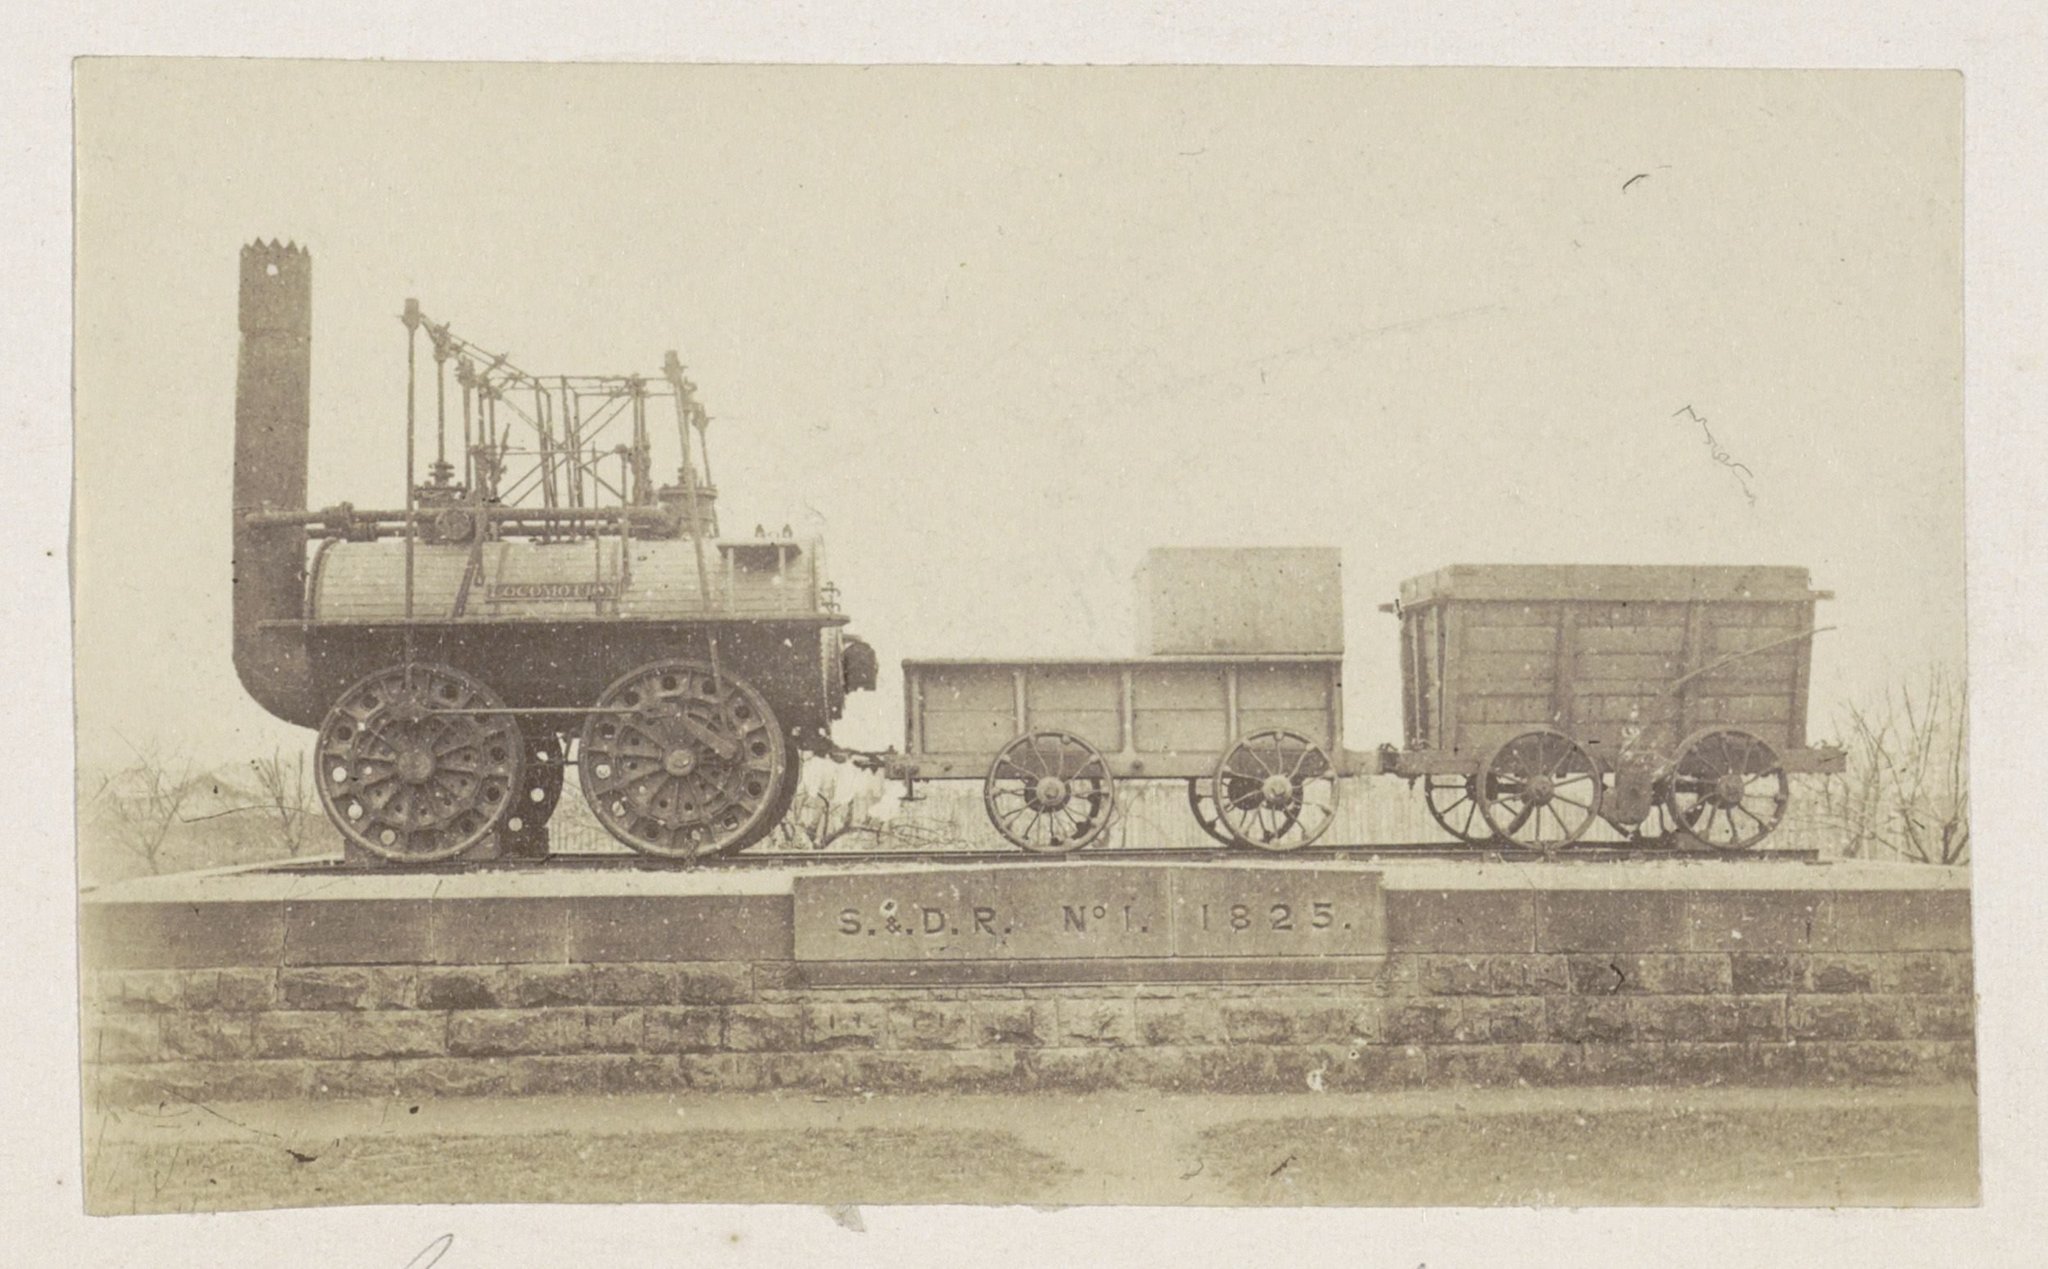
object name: photograph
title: Locomotief met aanhangwagens op een sokkel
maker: Anonymous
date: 1878-1890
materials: photographic support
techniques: albumen print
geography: darlington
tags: monument, statue, steam locomotive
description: Op een gemetselde sokkel staat een stoomlocomotief met een tender voor water en brandstof en een wagon. Daaronder is in steen de tekst uitgehouwen: 'S.&D.R. No. 1. 1825.'. Dit verwijst naar de Locomotion No. 1., de eerste locomotief die reed op het traject van de Stockton and Darlington Railway (S.&D.R.) en gebouwd werd door George Stephenson (1781-1848). Onderdeel van Reisalbum Europese steden, vermoedelijk Zweeds.